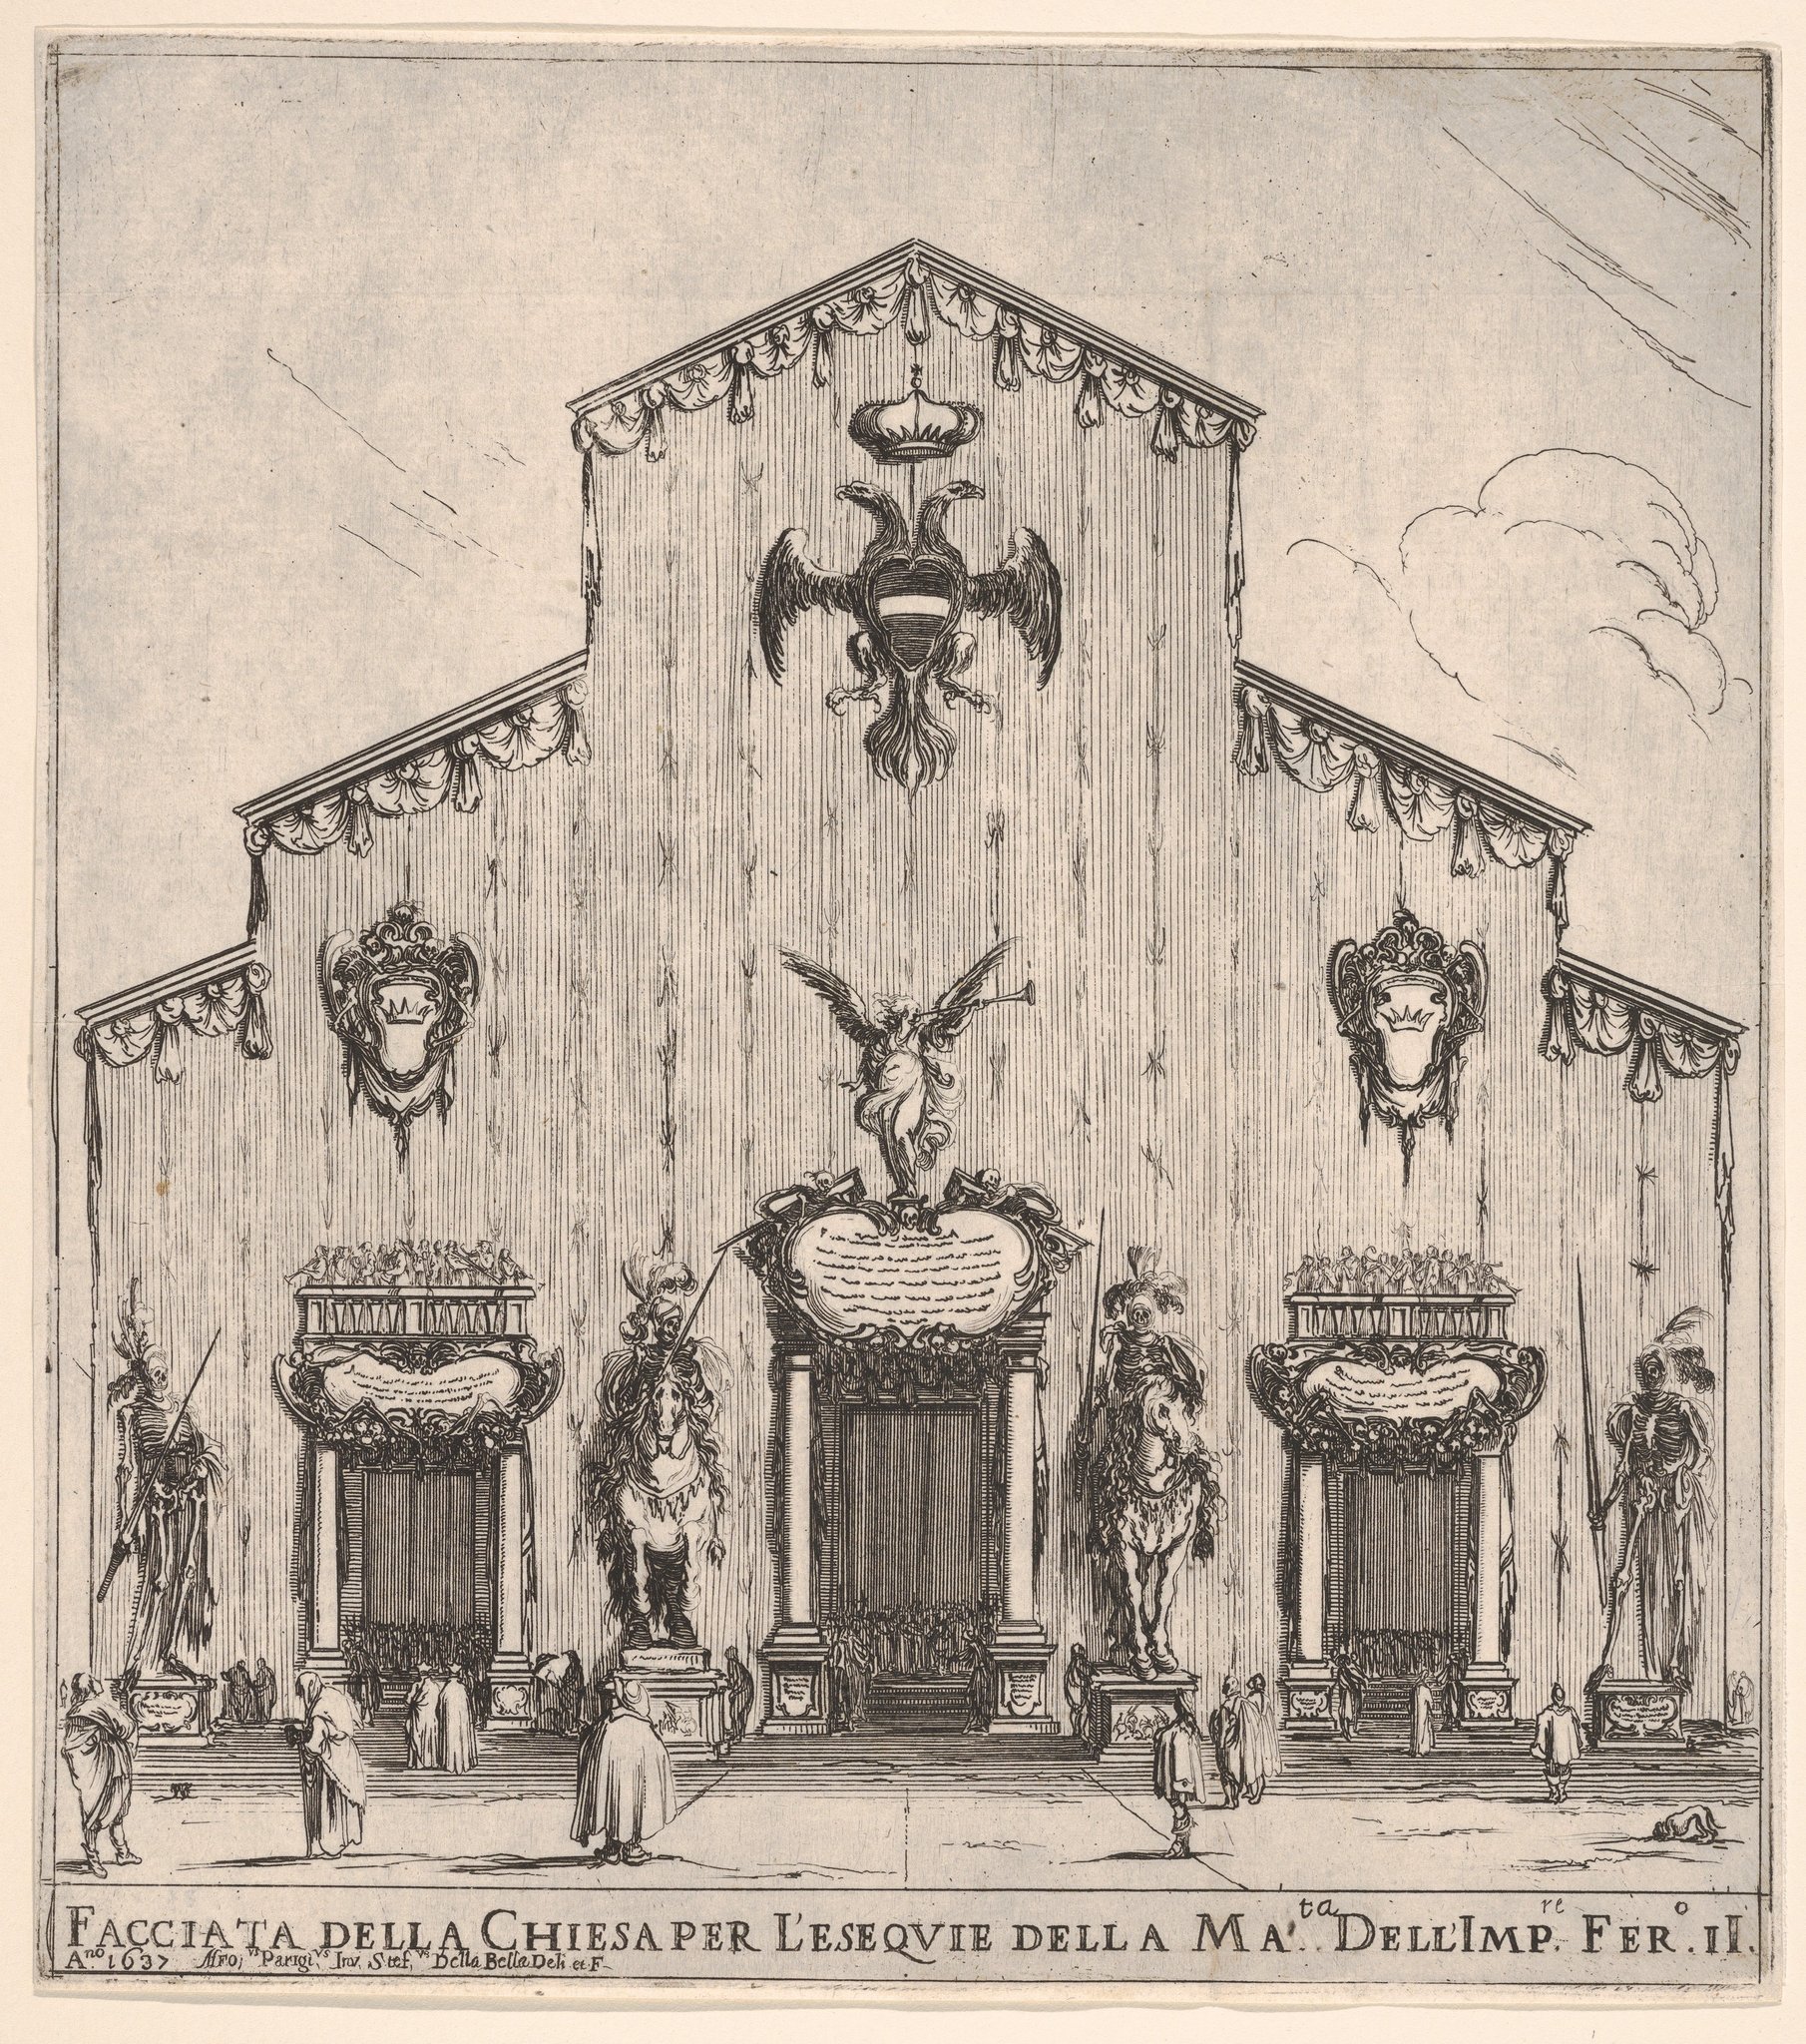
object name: print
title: Façade of the church of San Lorenzo in Florence, decorated with the emperor's arms, four figures of death flanking the three entrances, the two in center on horseback, a large angel above central door, from "Ceremonies for the Funeral of Emperor Ferdinand II" (Funérailles de l'empereur Ferdinand II)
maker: stefano della bella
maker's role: artist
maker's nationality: italian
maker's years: 1610-1664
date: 1637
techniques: etching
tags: architecture,churches